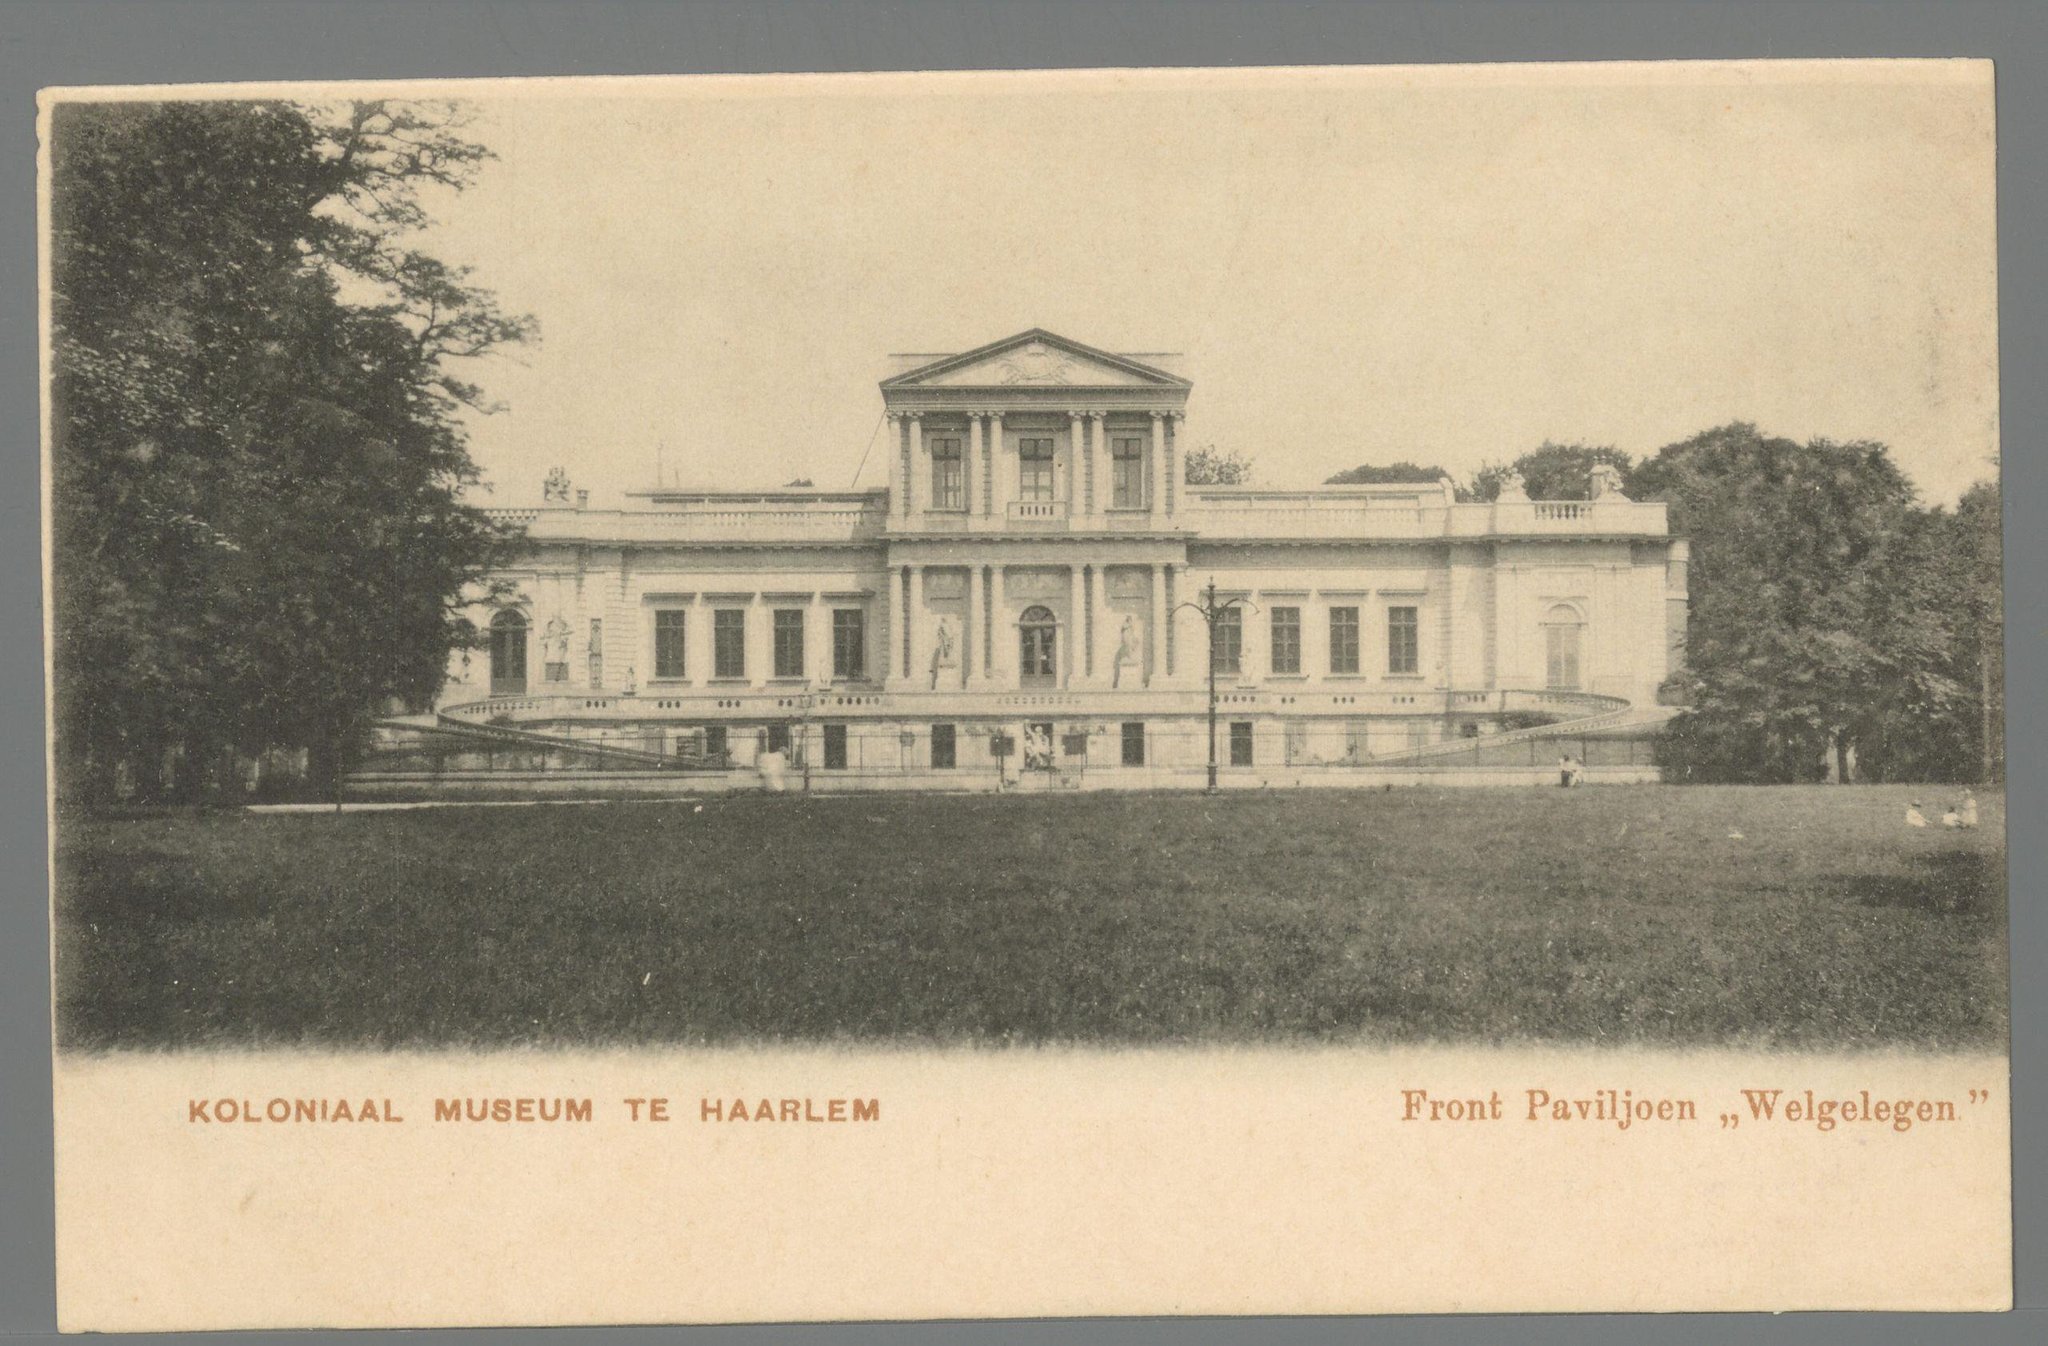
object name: photomechanical print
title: Koloniaal Museum te Haarlem. Front Paviljoen "Welgelegen"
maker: Anonymous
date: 1892-1905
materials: cardboard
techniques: photograph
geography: haarlem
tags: permanent exhibition, museum, haarlem